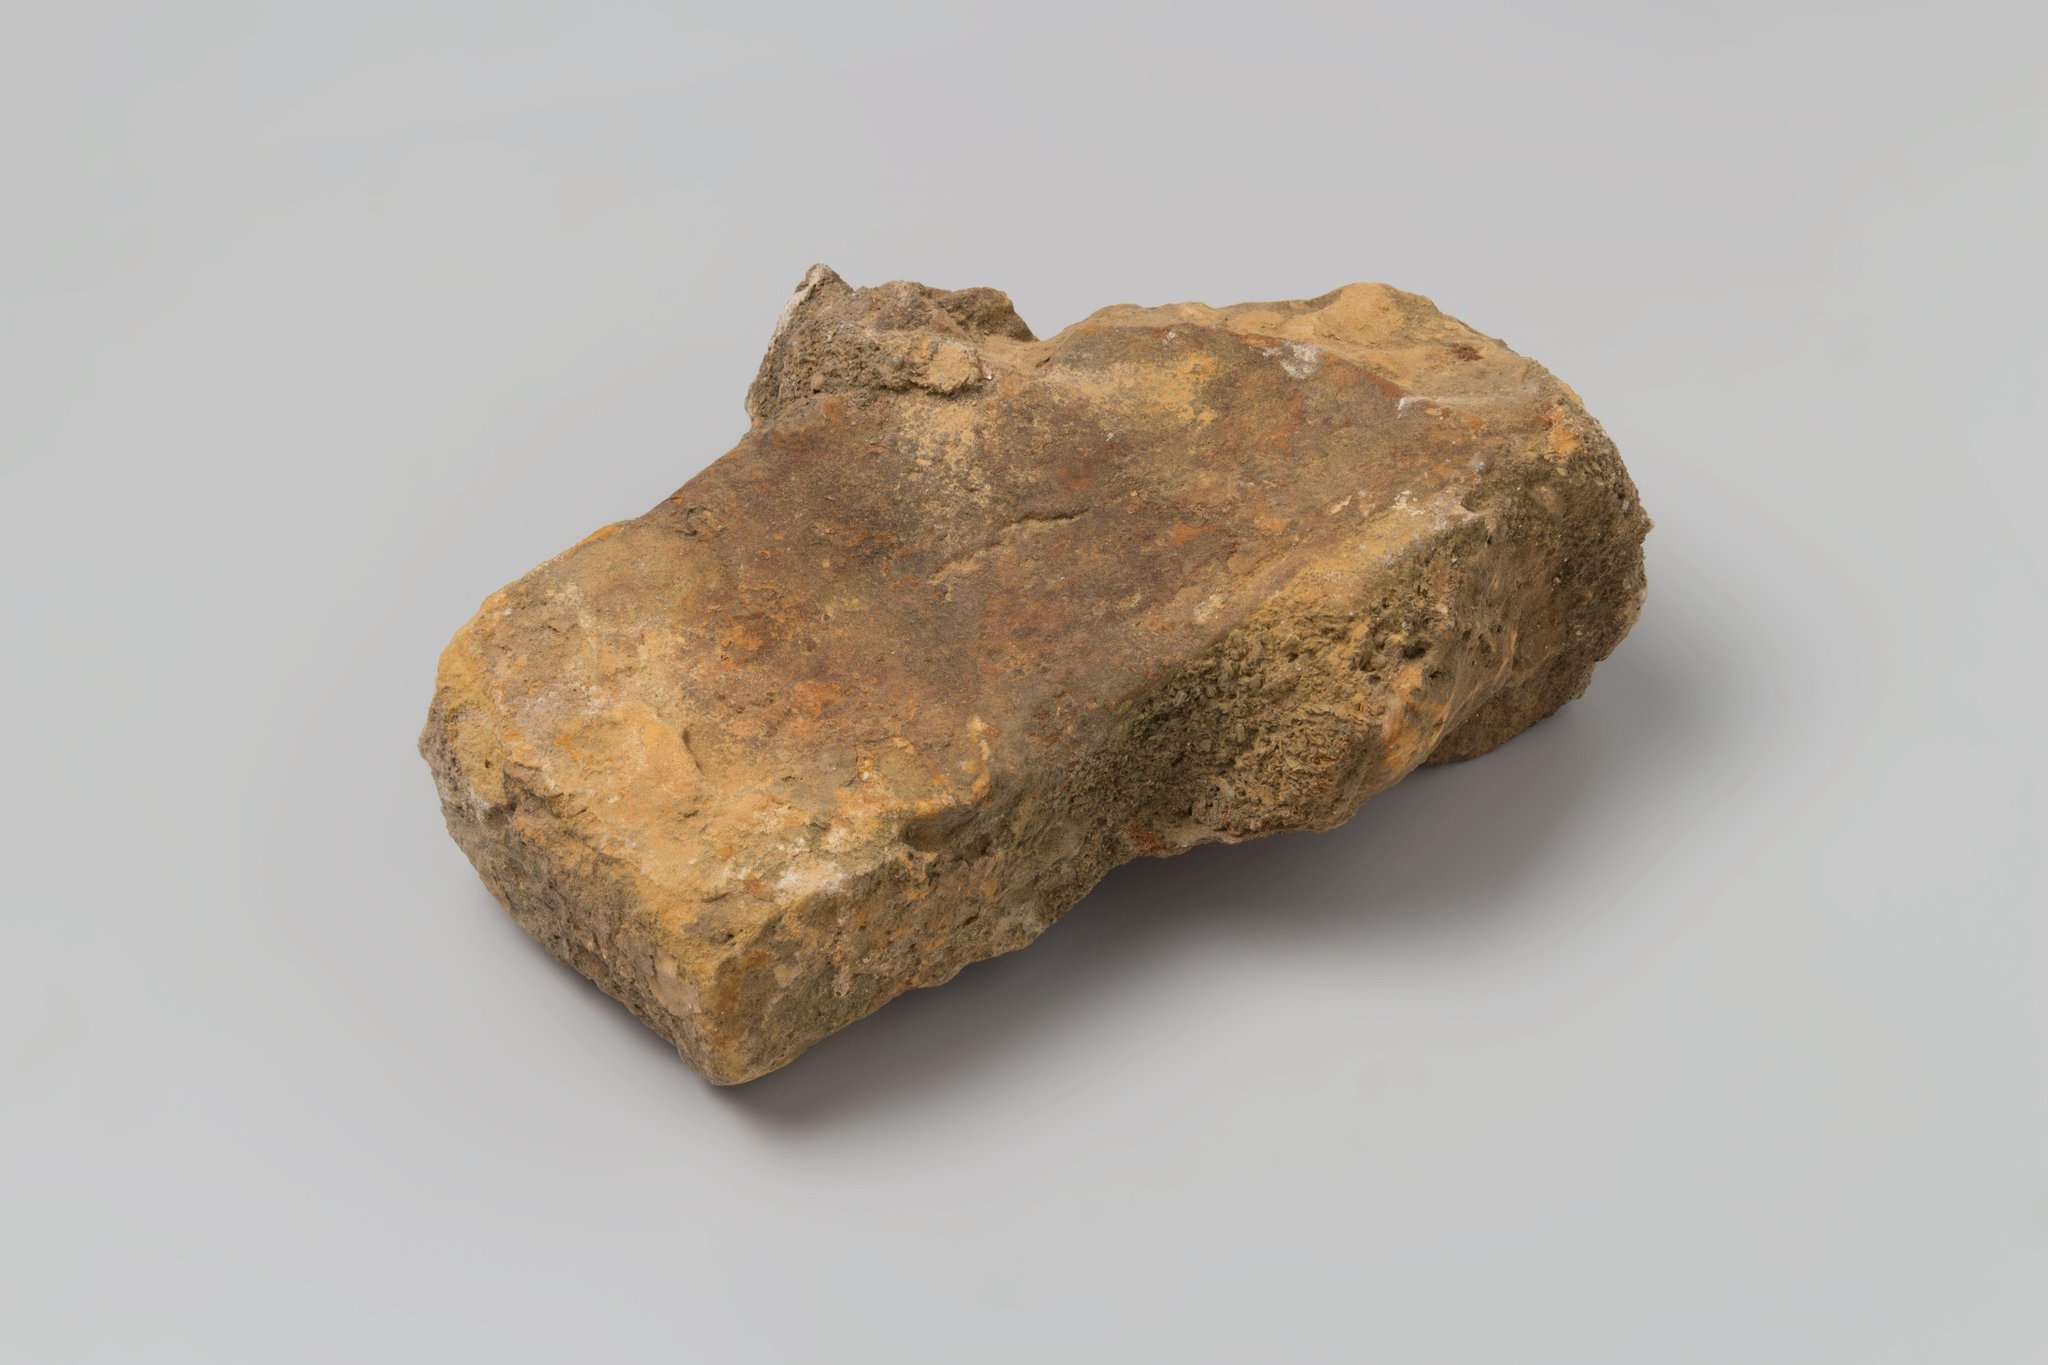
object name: brick clay product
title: Deel van een baksteen met stuk concretie uit het wrak van de Oost-Indiëvaarder 't Vliegend Hart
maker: Anonymous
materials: brick, stone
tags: 't vliegend hart (schip), verenigde oostindische compagnie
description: Deel van een rechthoekige, geelbruine baksteen met stuk concretie. Brick.